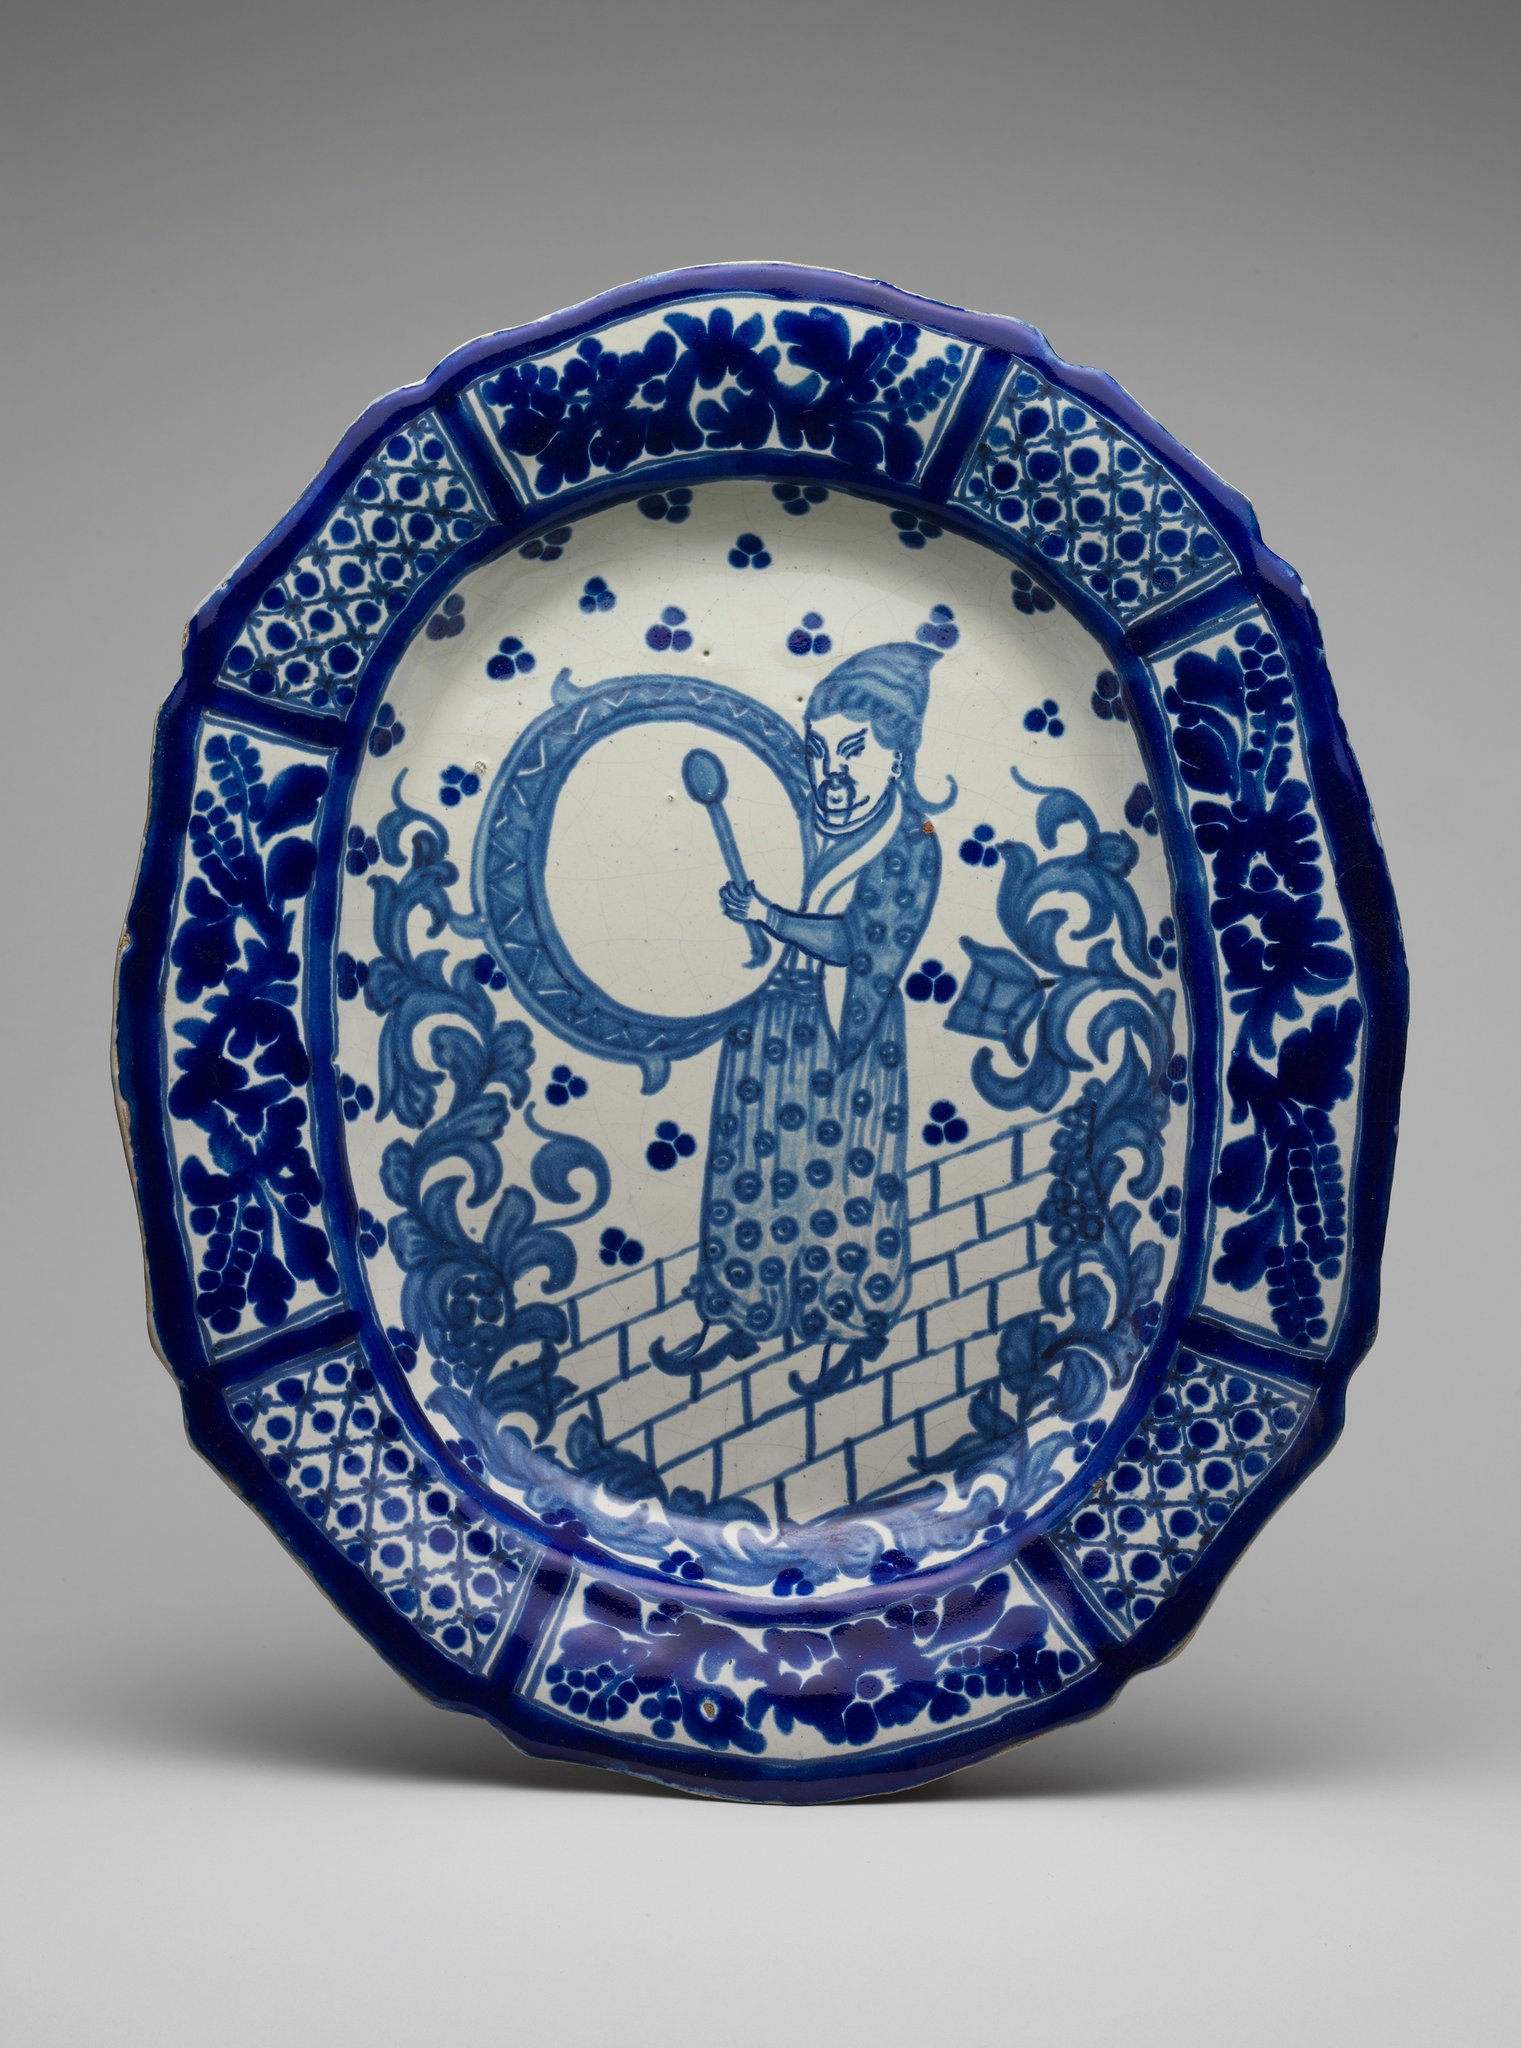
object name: dish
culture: mexican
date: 1830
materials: earthenware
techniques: glazing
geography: mexico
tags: men,drums